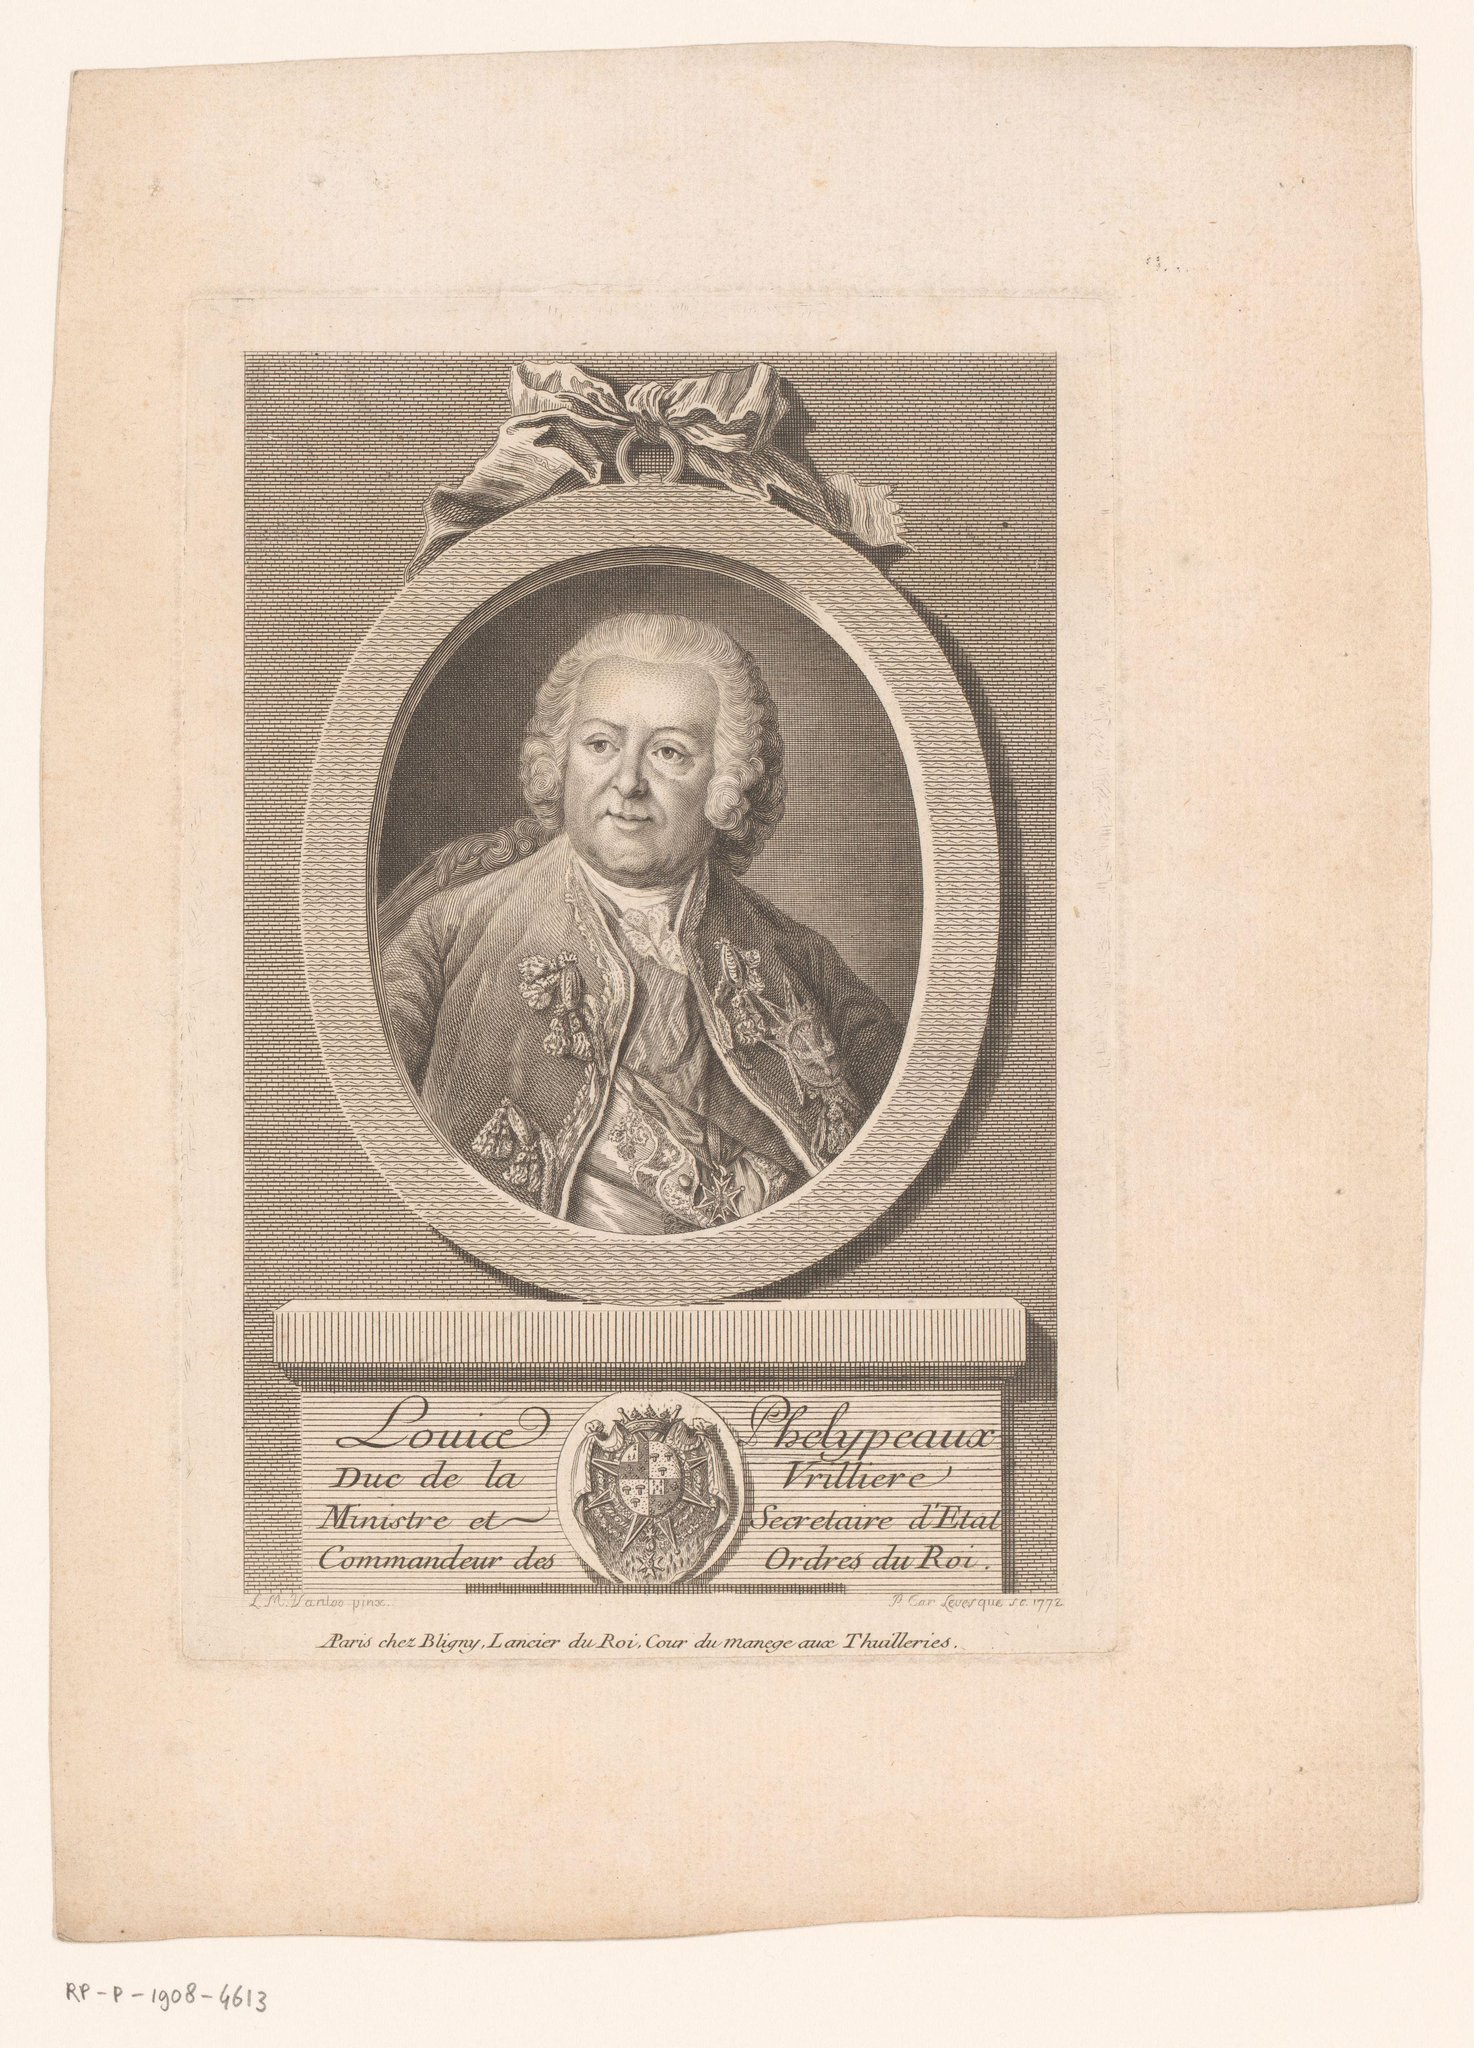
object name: print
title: Portret van Louis Phélypeaux de Saint-Florentin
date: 1772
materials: paper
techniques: engraving, etching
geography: paris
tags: louis phélypeaux de saint-florentin, historical persons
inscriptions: collector's mark: Lugt 2228